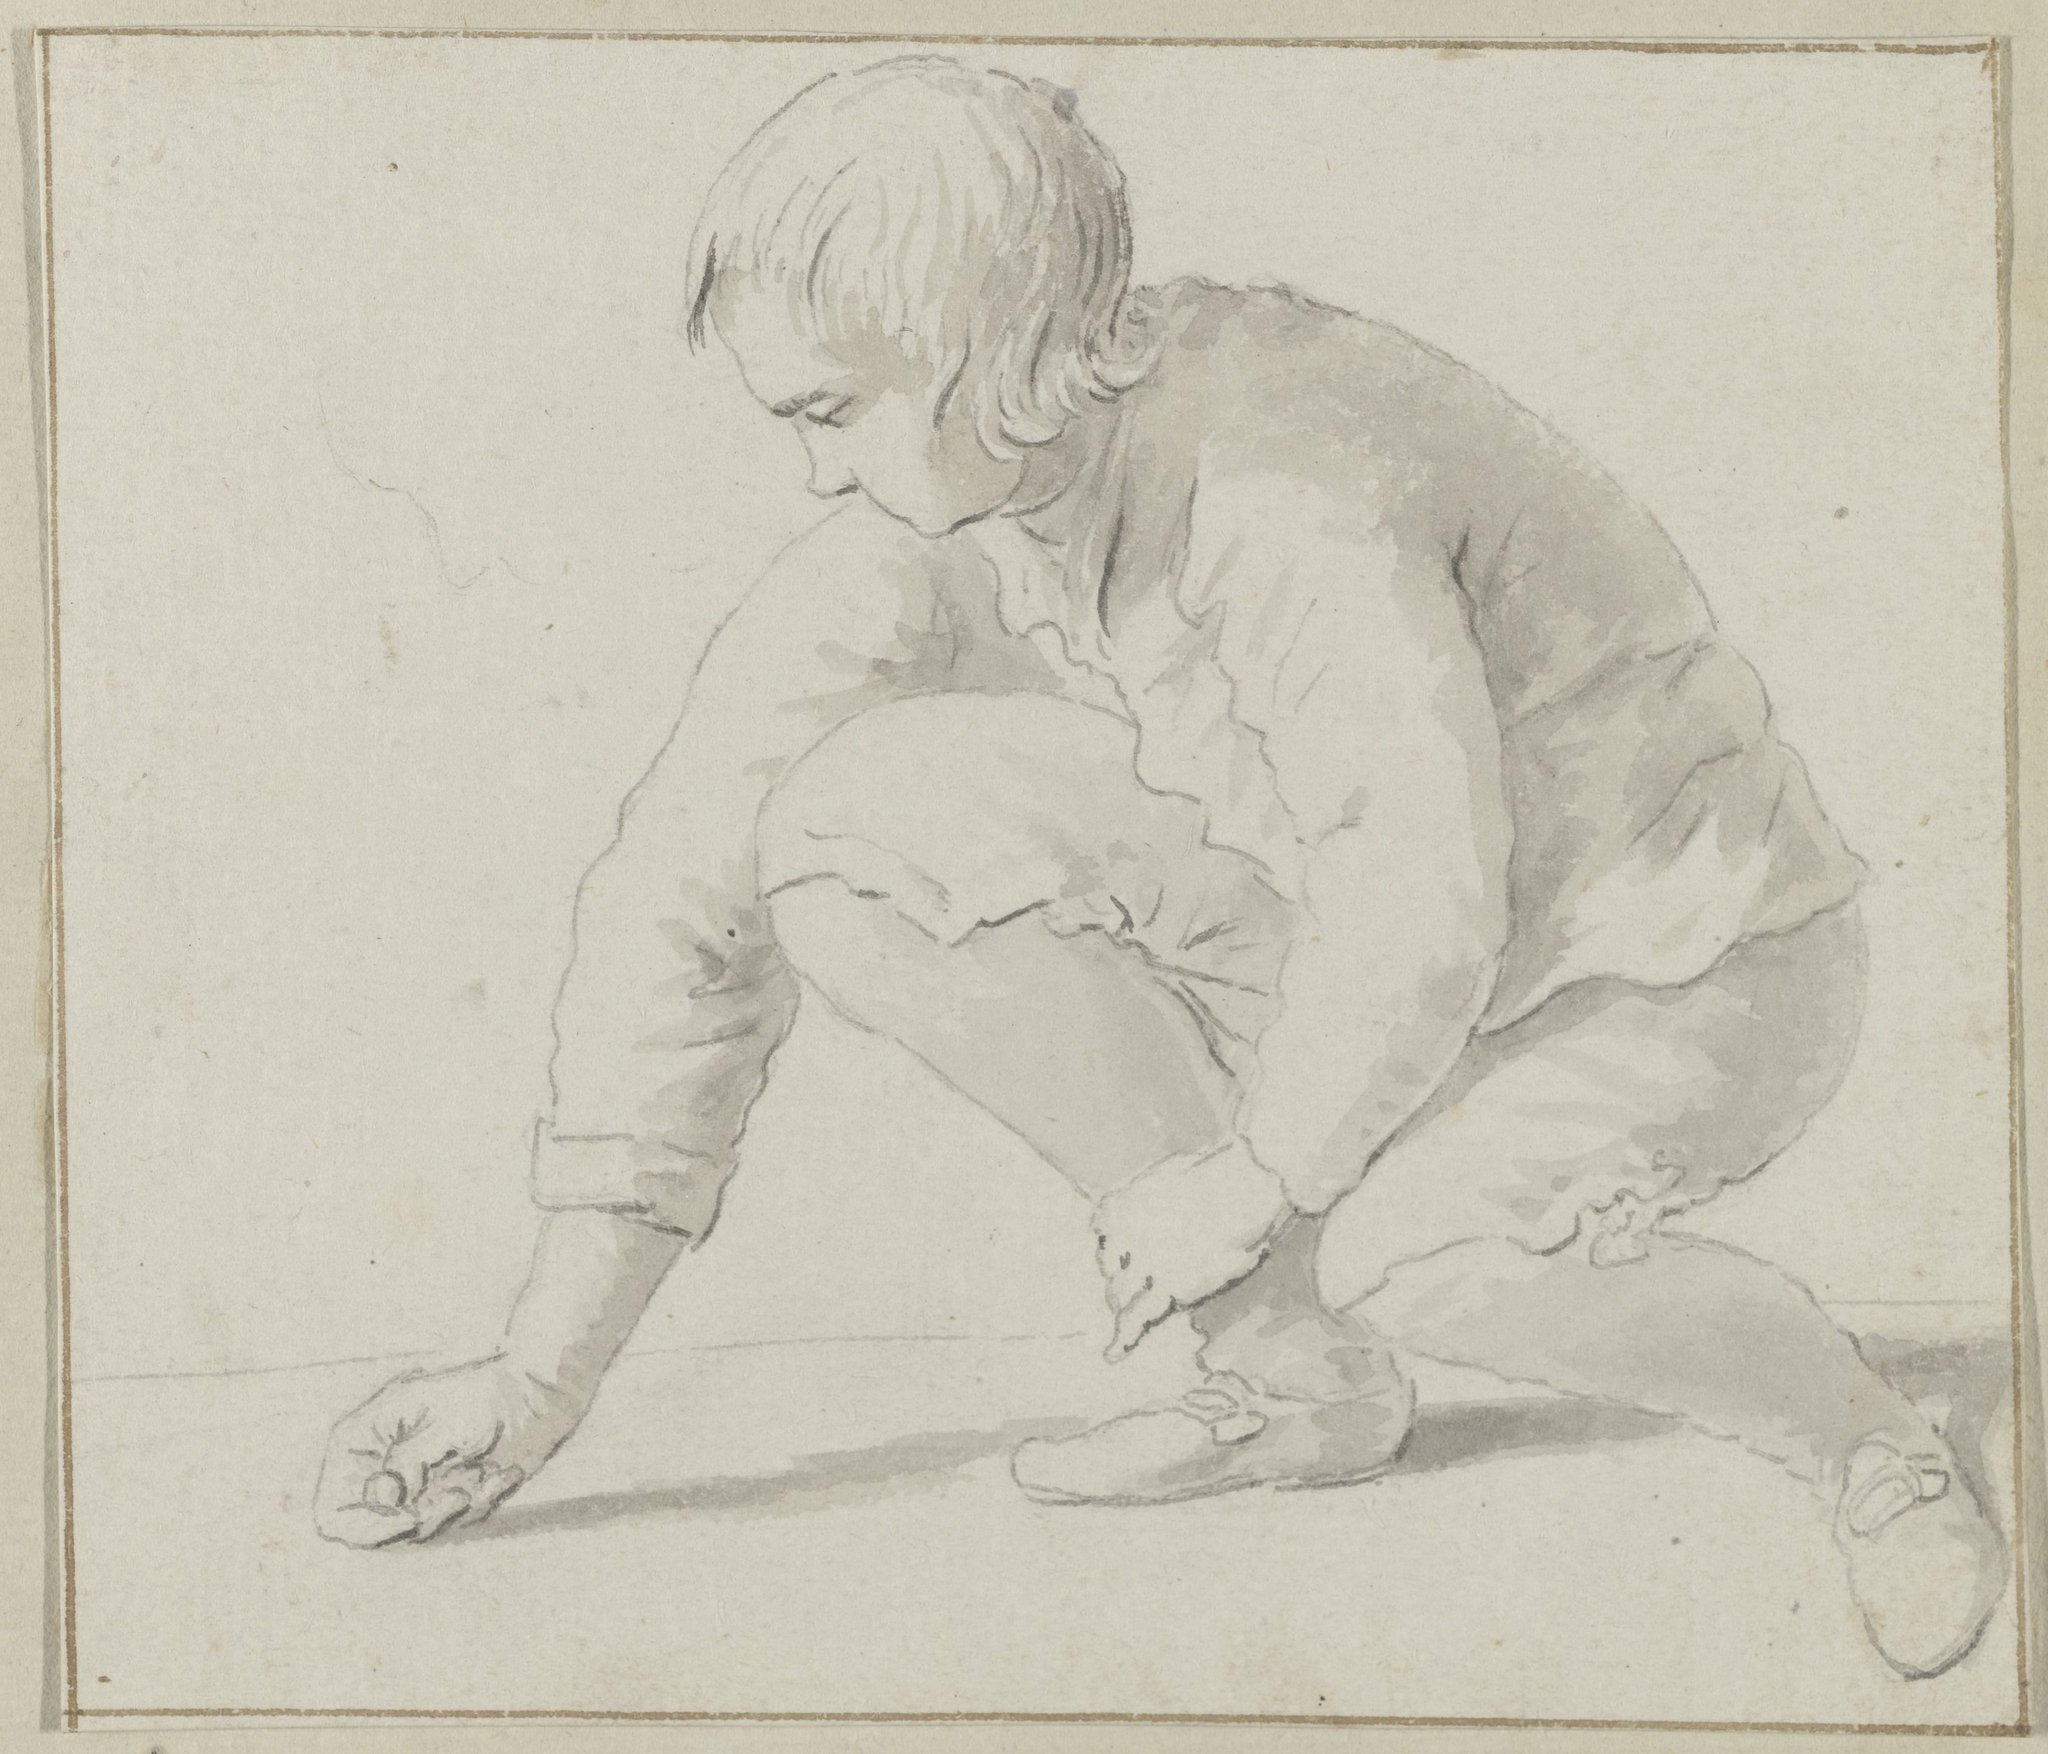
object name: drawing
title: Knikkerende jongen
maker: Anonymous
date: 1700-1799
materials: ink, paper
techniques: brush, pen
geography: netherlands